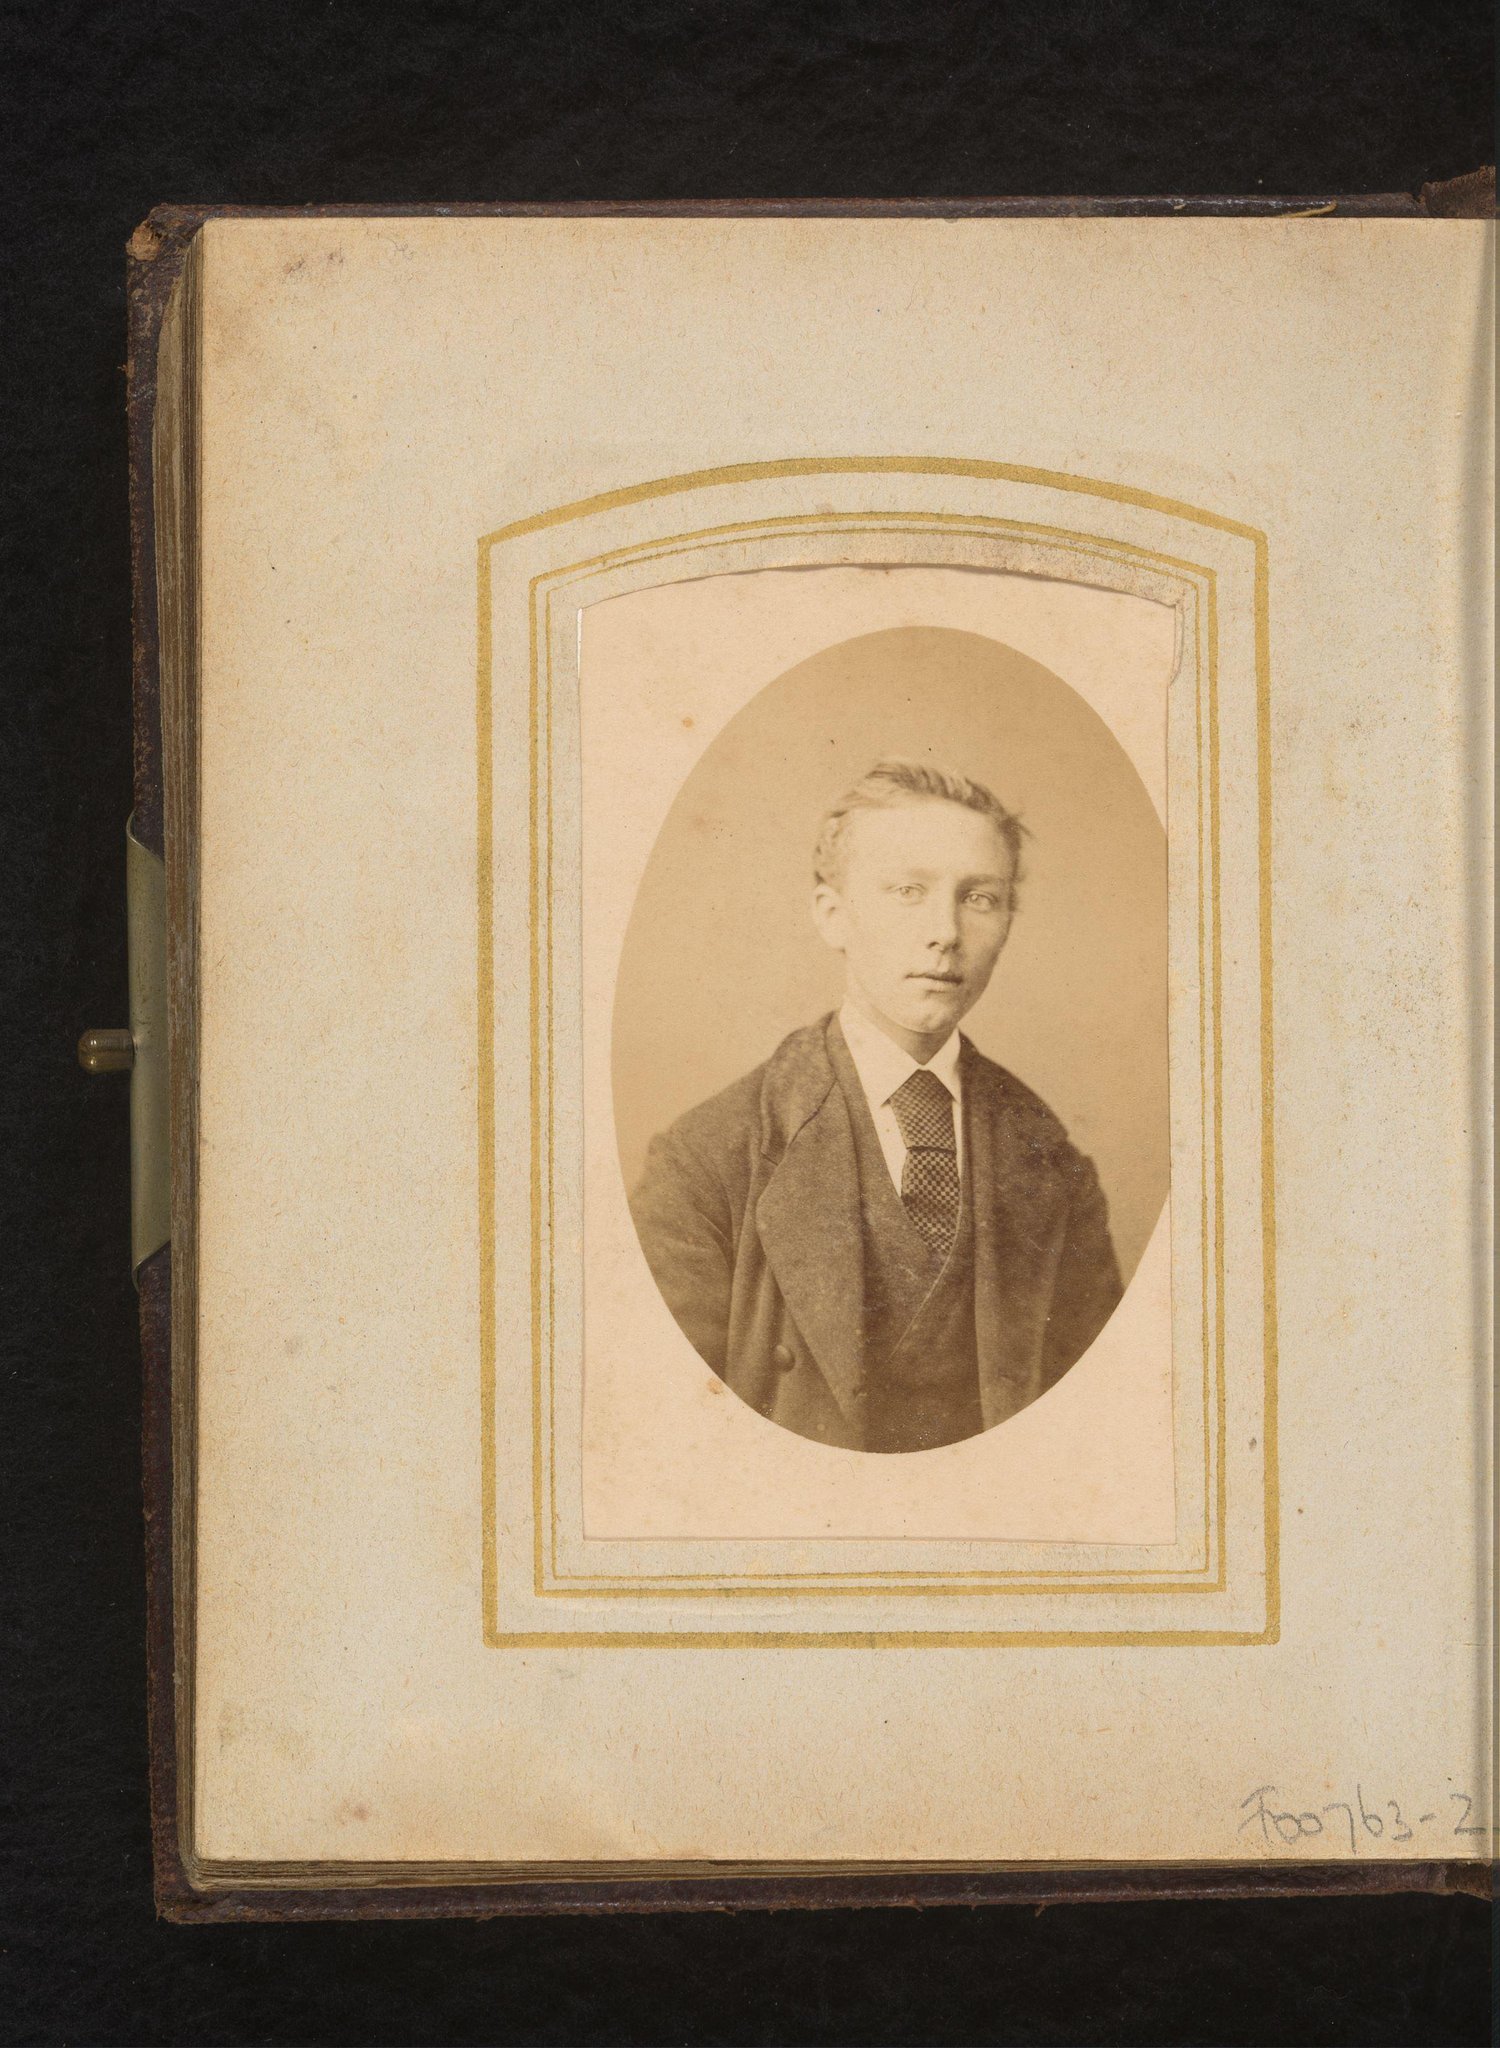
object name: carte de visite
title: Portret van een jonge man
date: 1870-1890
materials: cardboard, photographic support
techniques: albumen print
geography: zwolle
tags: historical persons, youth, adolescent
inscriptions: inscription: ‘Cohen's/ Photografische Inrigting/ Nieuwstraat/ Zwolle./ Van deze photographie kan steeds nabesteld worden.’